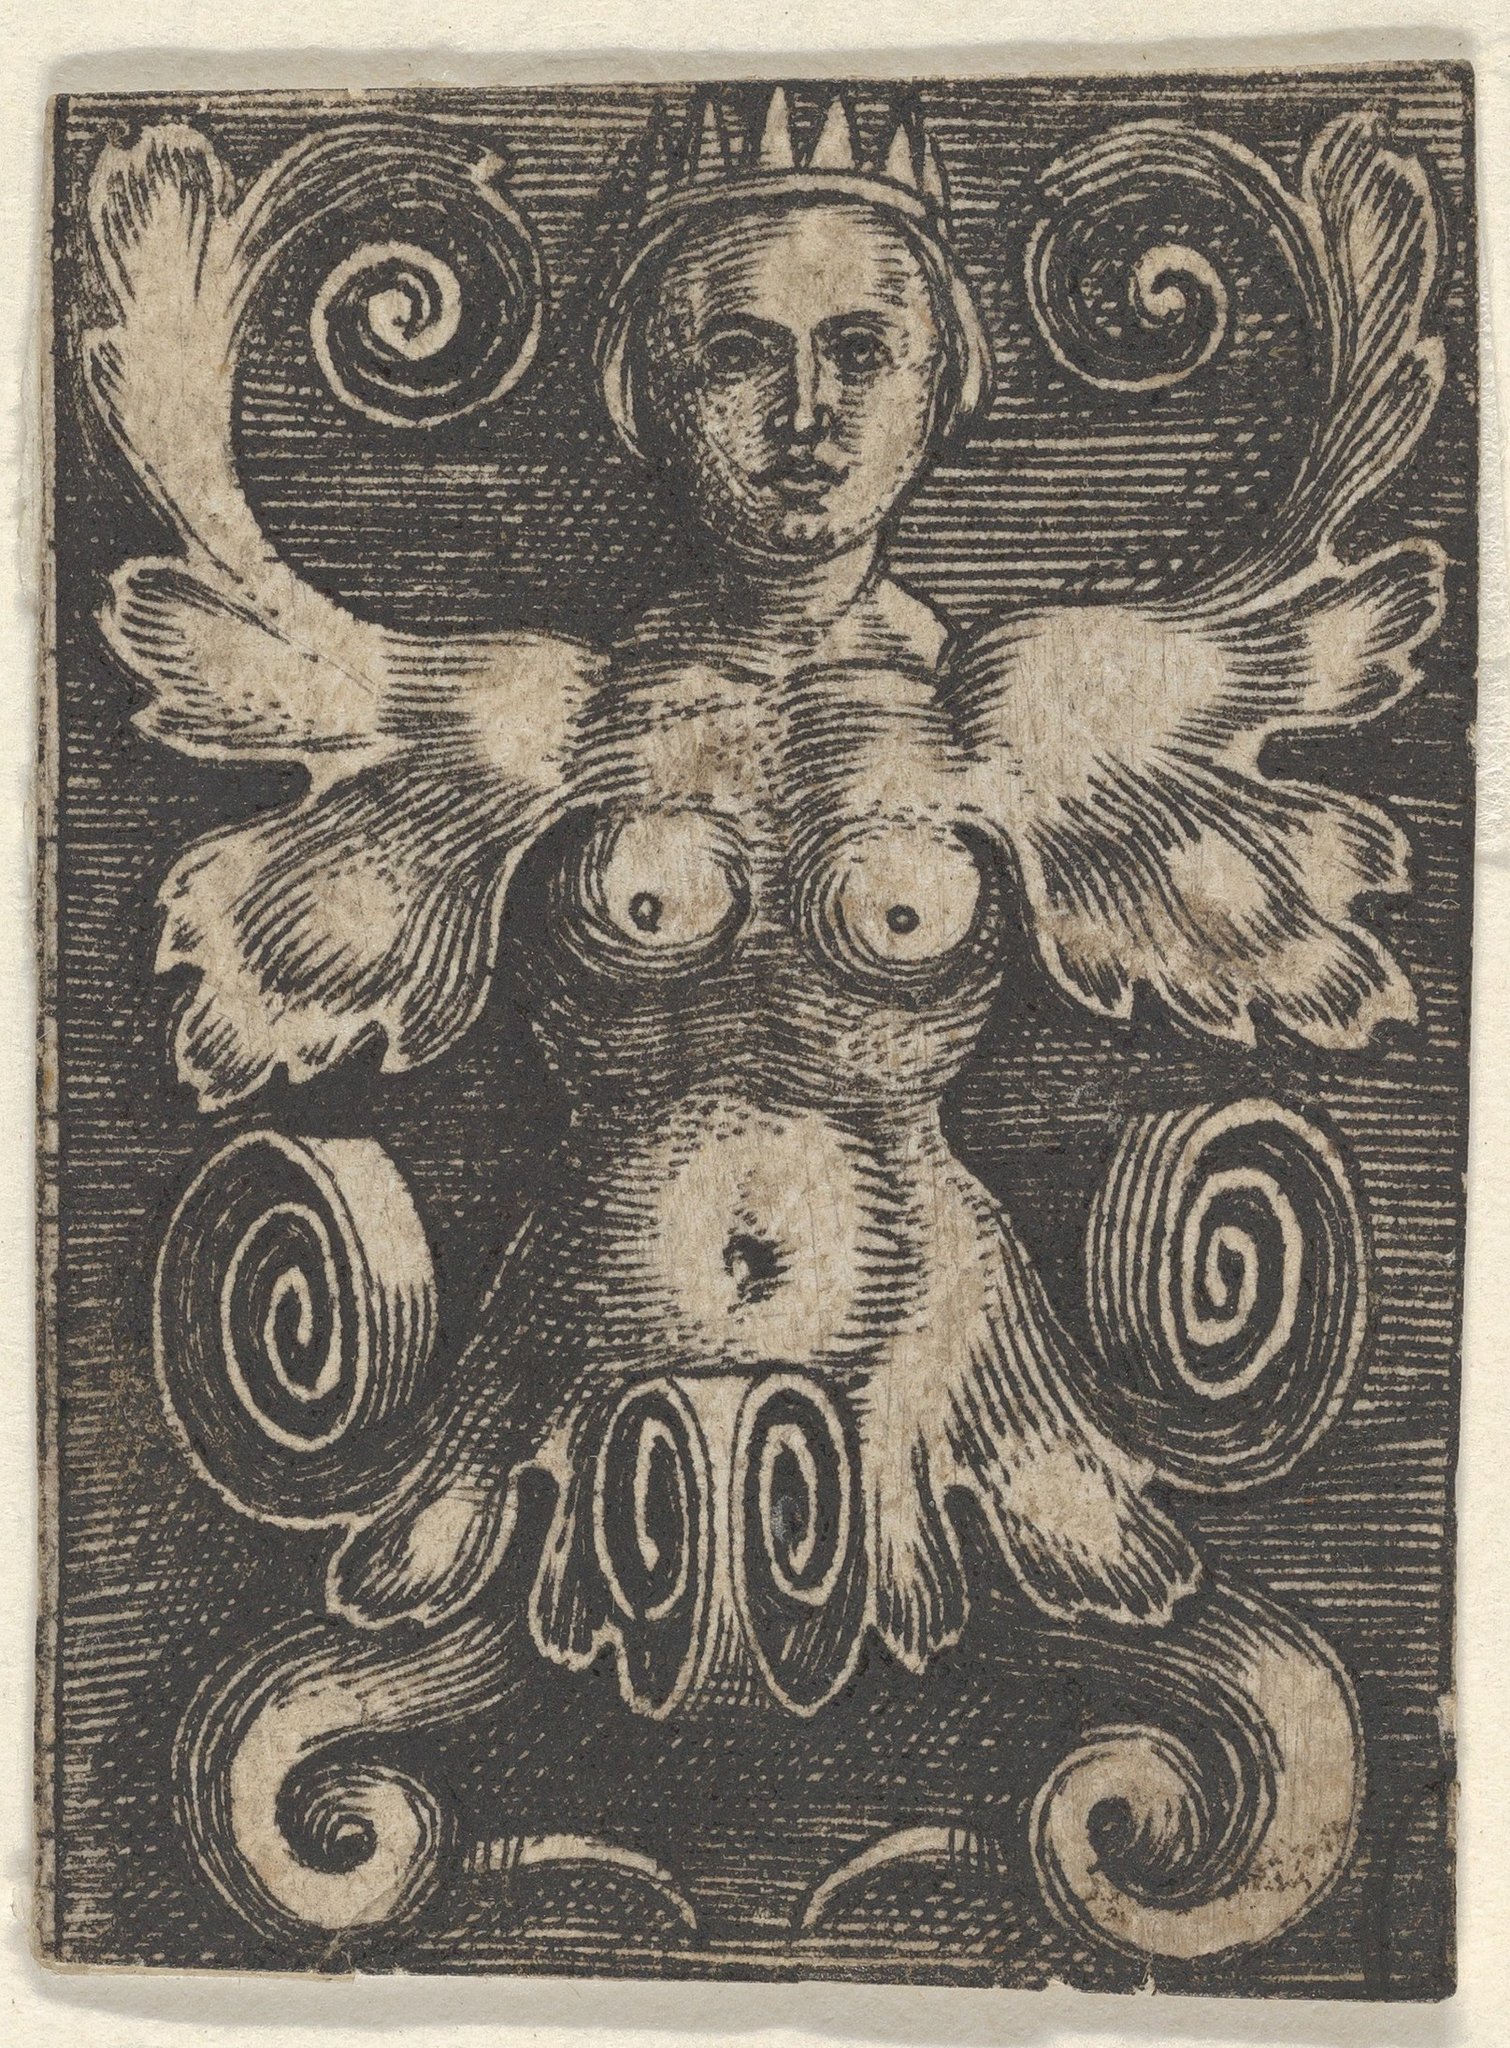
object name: print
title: Vertical Panel with a Half-Length Female with Leaves as Arms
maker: jacob binck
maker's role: artist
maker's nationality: german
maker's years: 1494-1569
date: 1520-1561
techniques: engraving